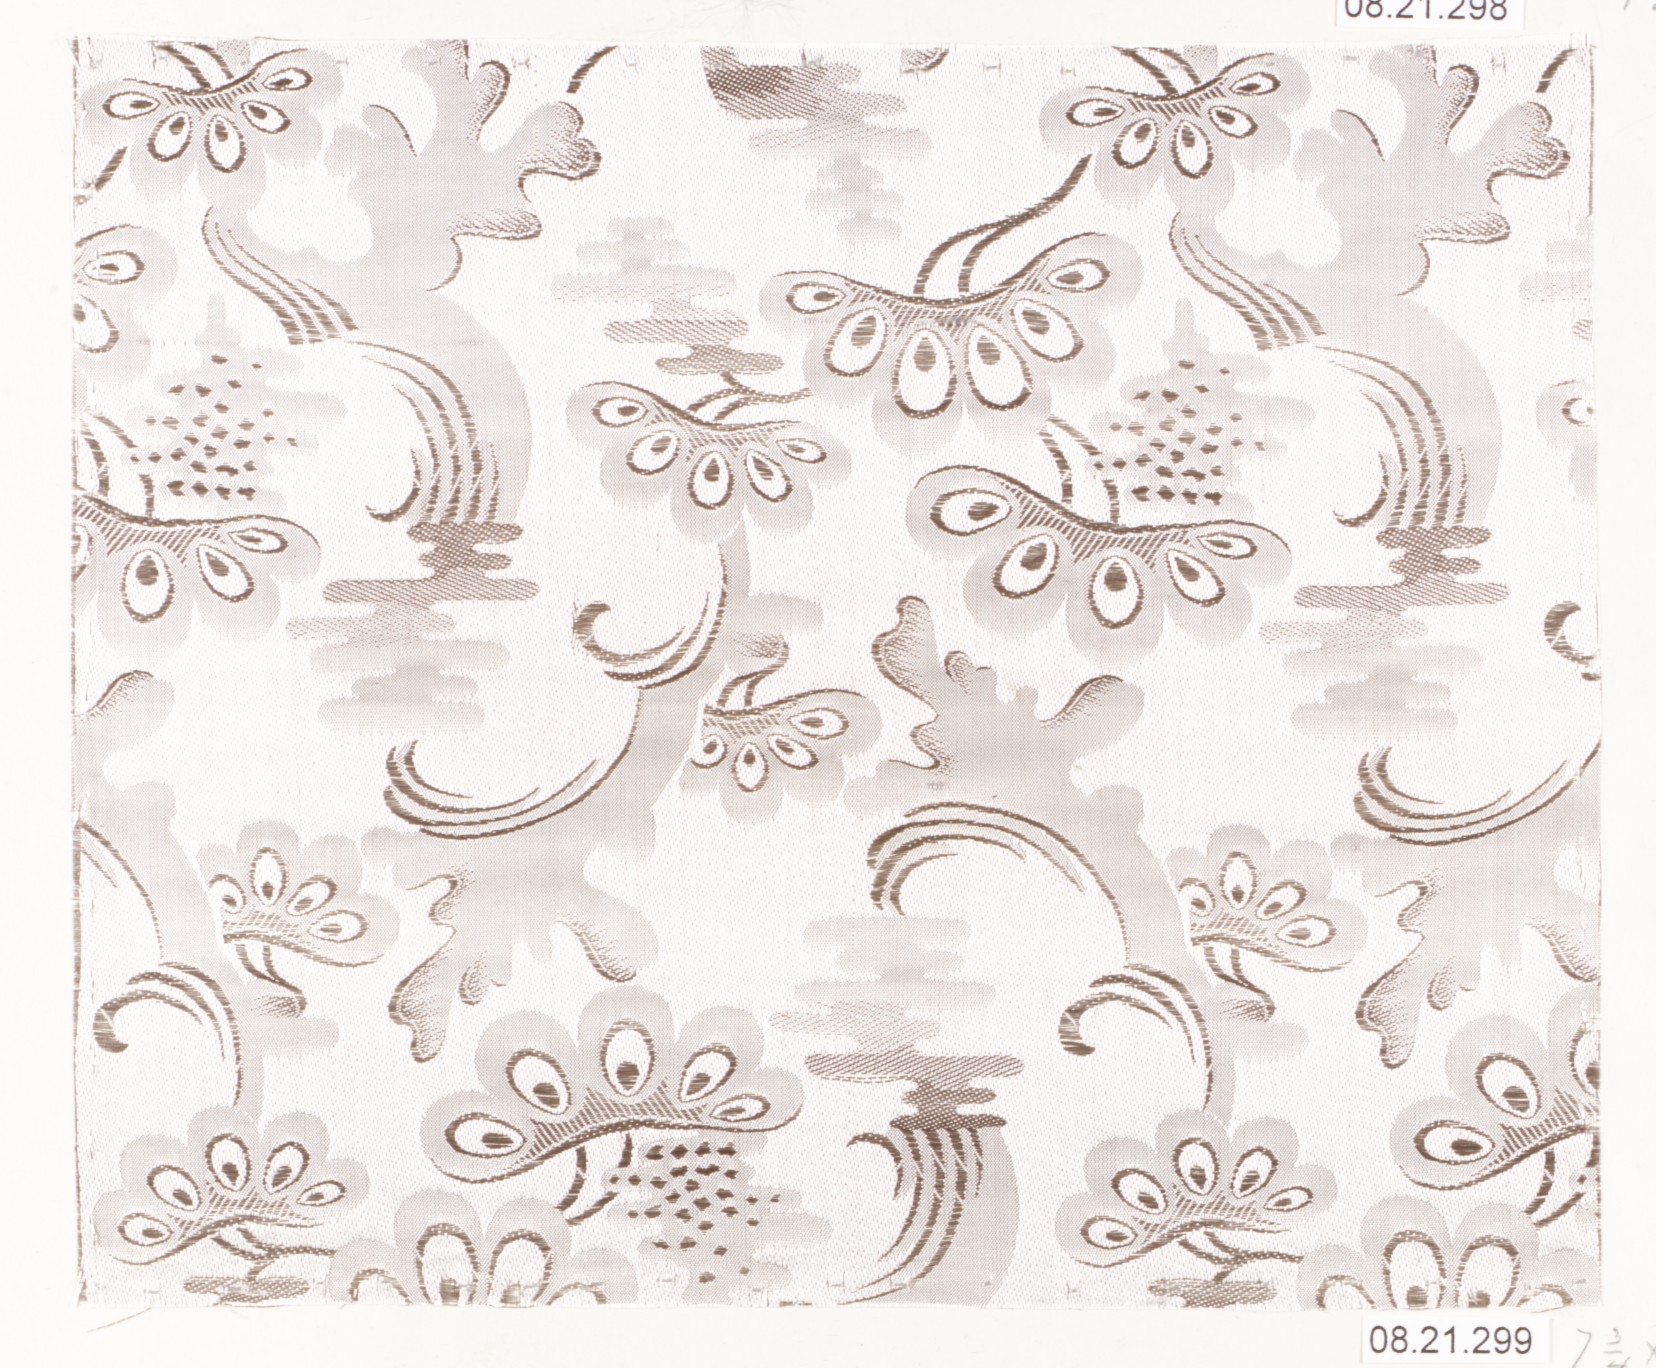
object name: textile sample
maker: Anonymous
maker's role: designer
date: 1900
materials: silk